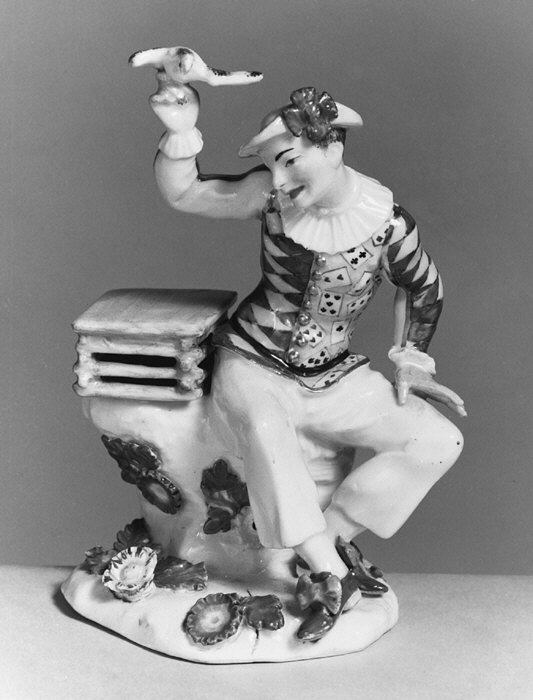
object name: figure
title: Harlequin with dove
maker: meissen manufactory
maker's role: manufactory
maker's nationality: german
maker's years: 1710-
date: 1743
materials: hard paste porcelain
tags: doves,men